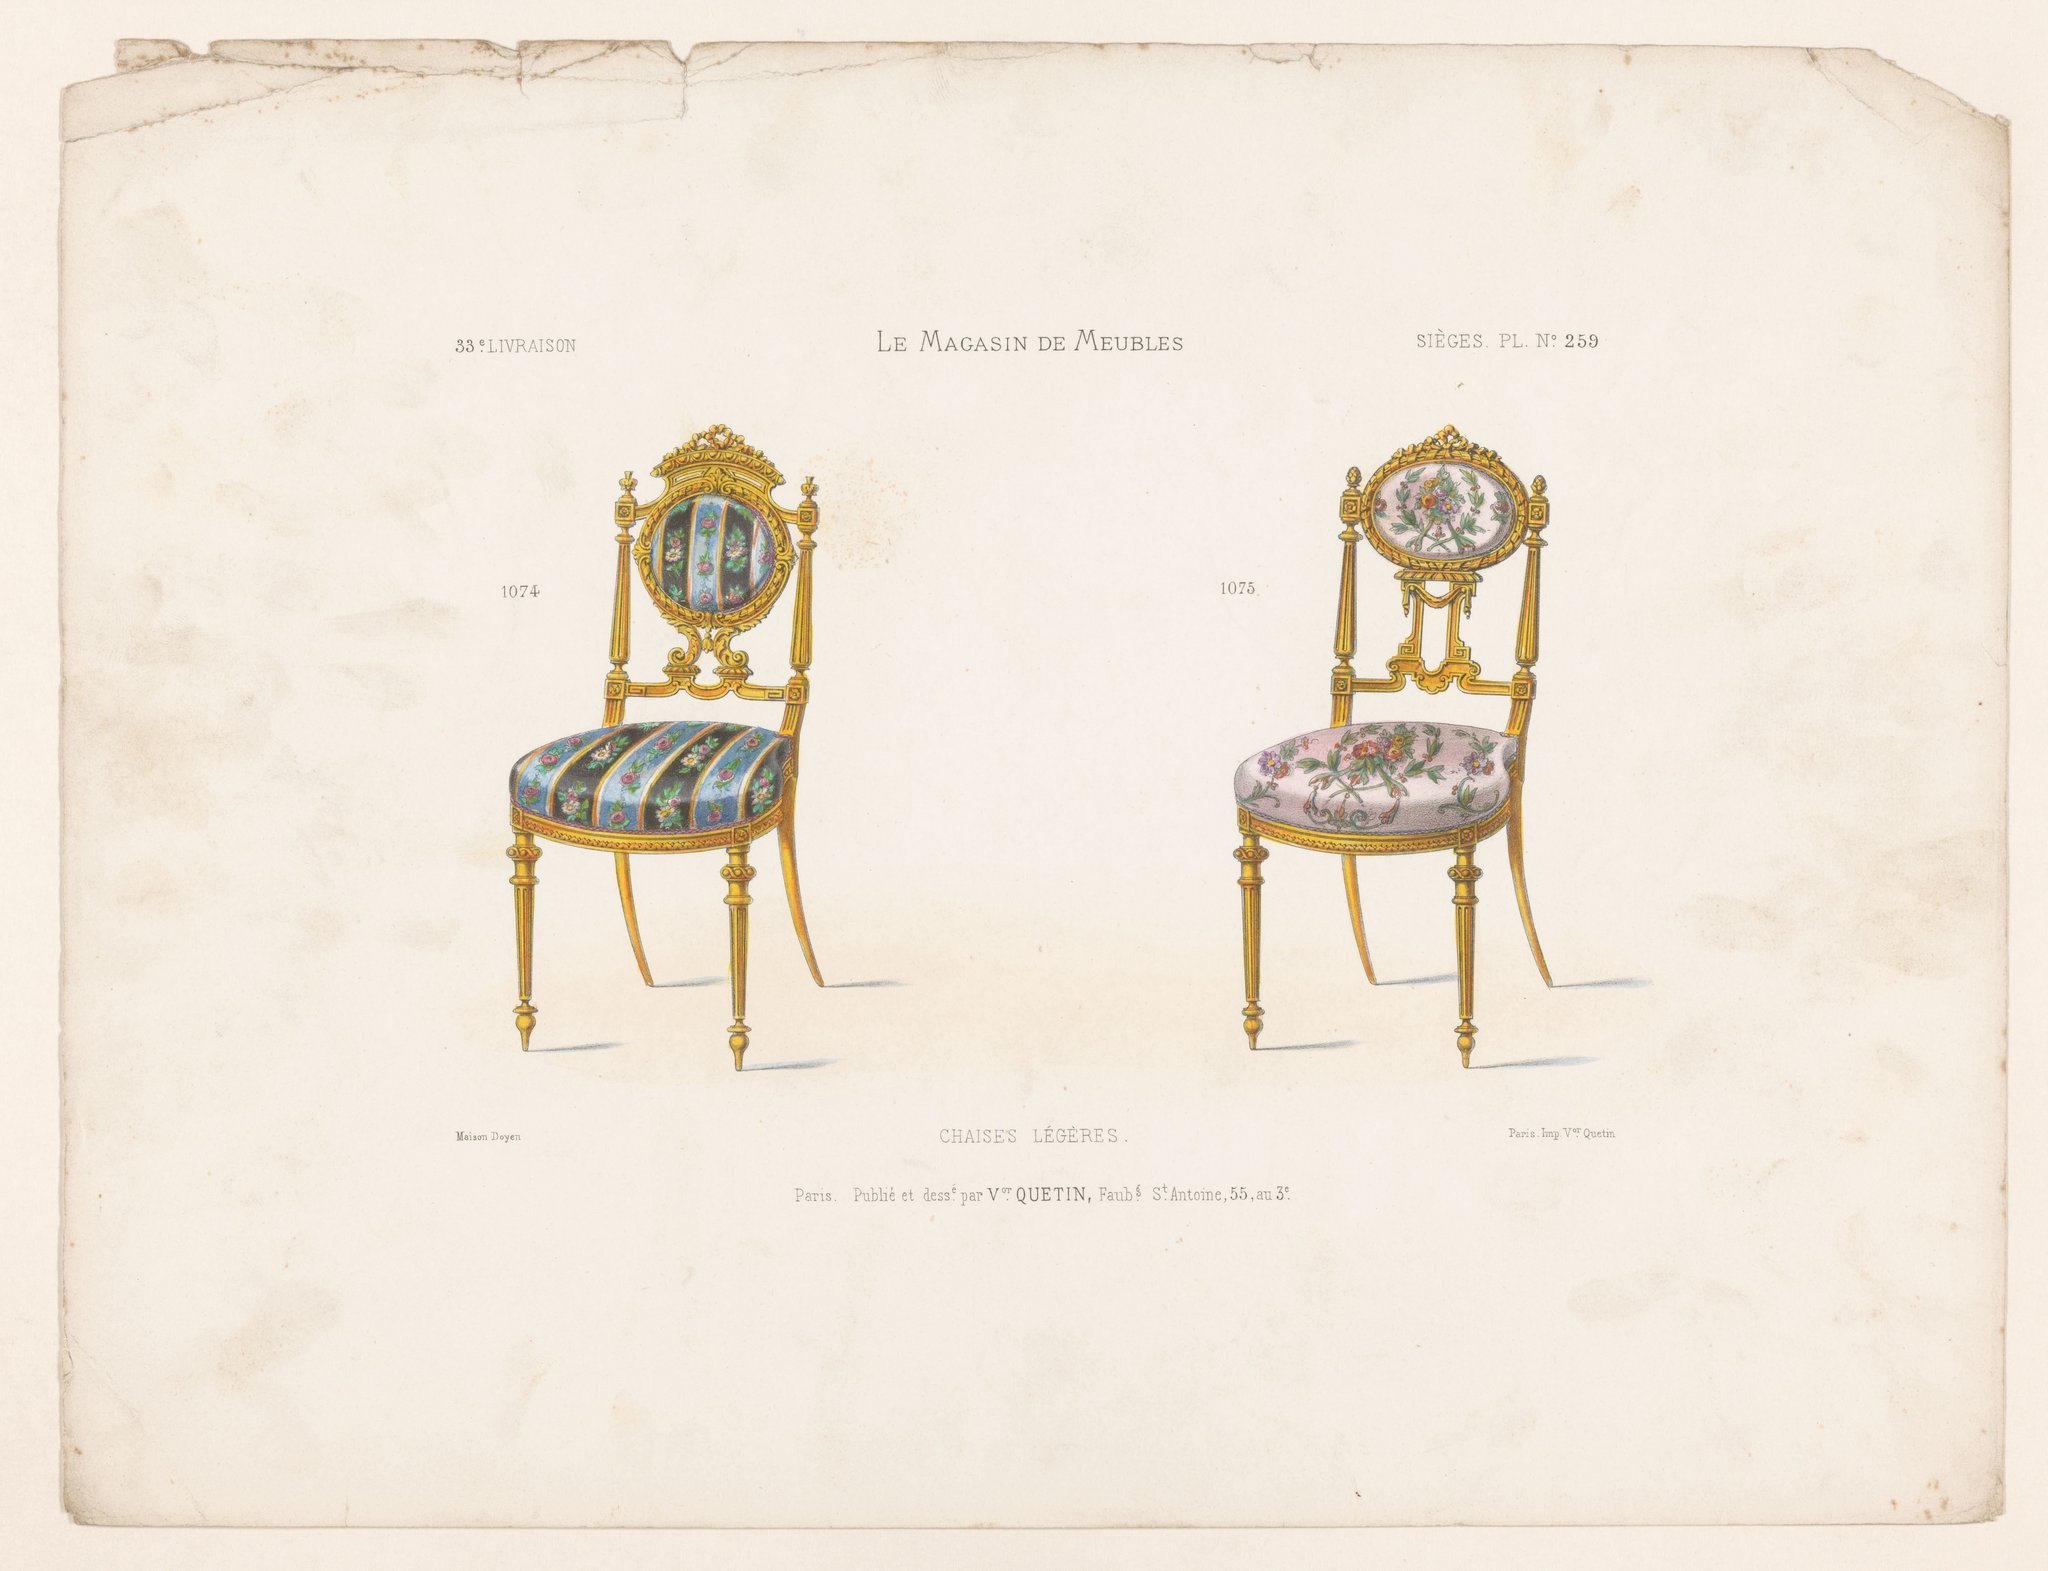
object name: print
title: Twee stoelen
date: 1832-1877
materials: paper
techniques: hand coloring, lithograph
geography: paris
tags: seating furniture